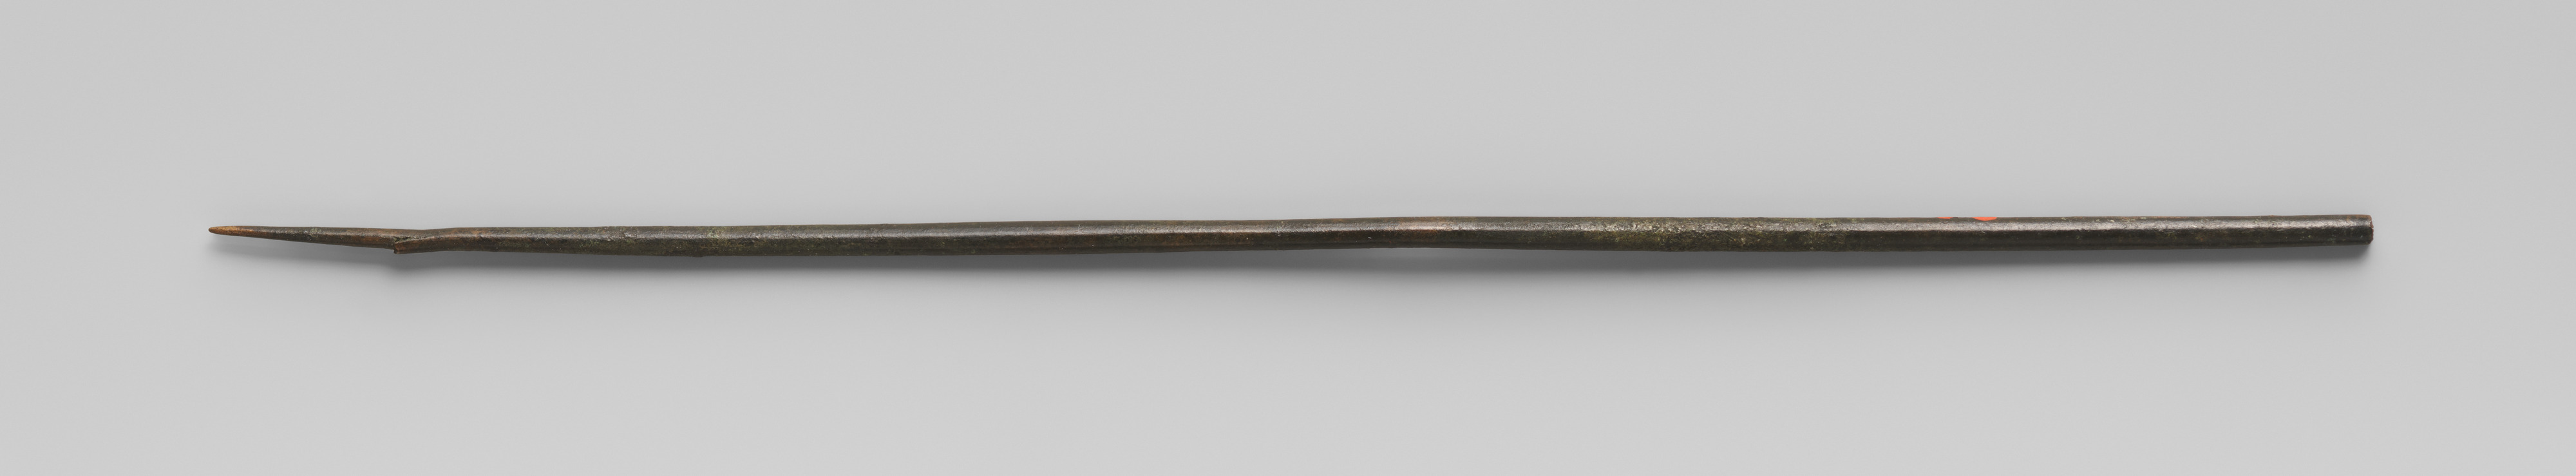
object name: tool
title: Implement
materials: copper alloy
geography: egypt